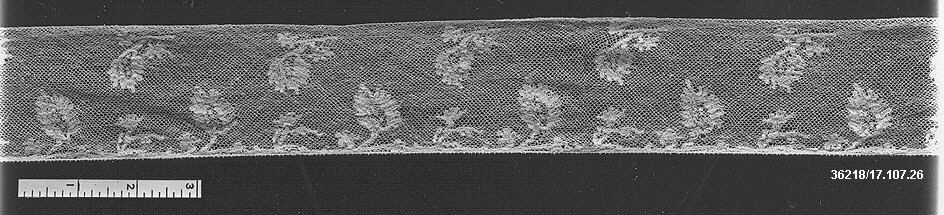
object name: piece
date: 1701-1900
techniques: lace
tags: leaves